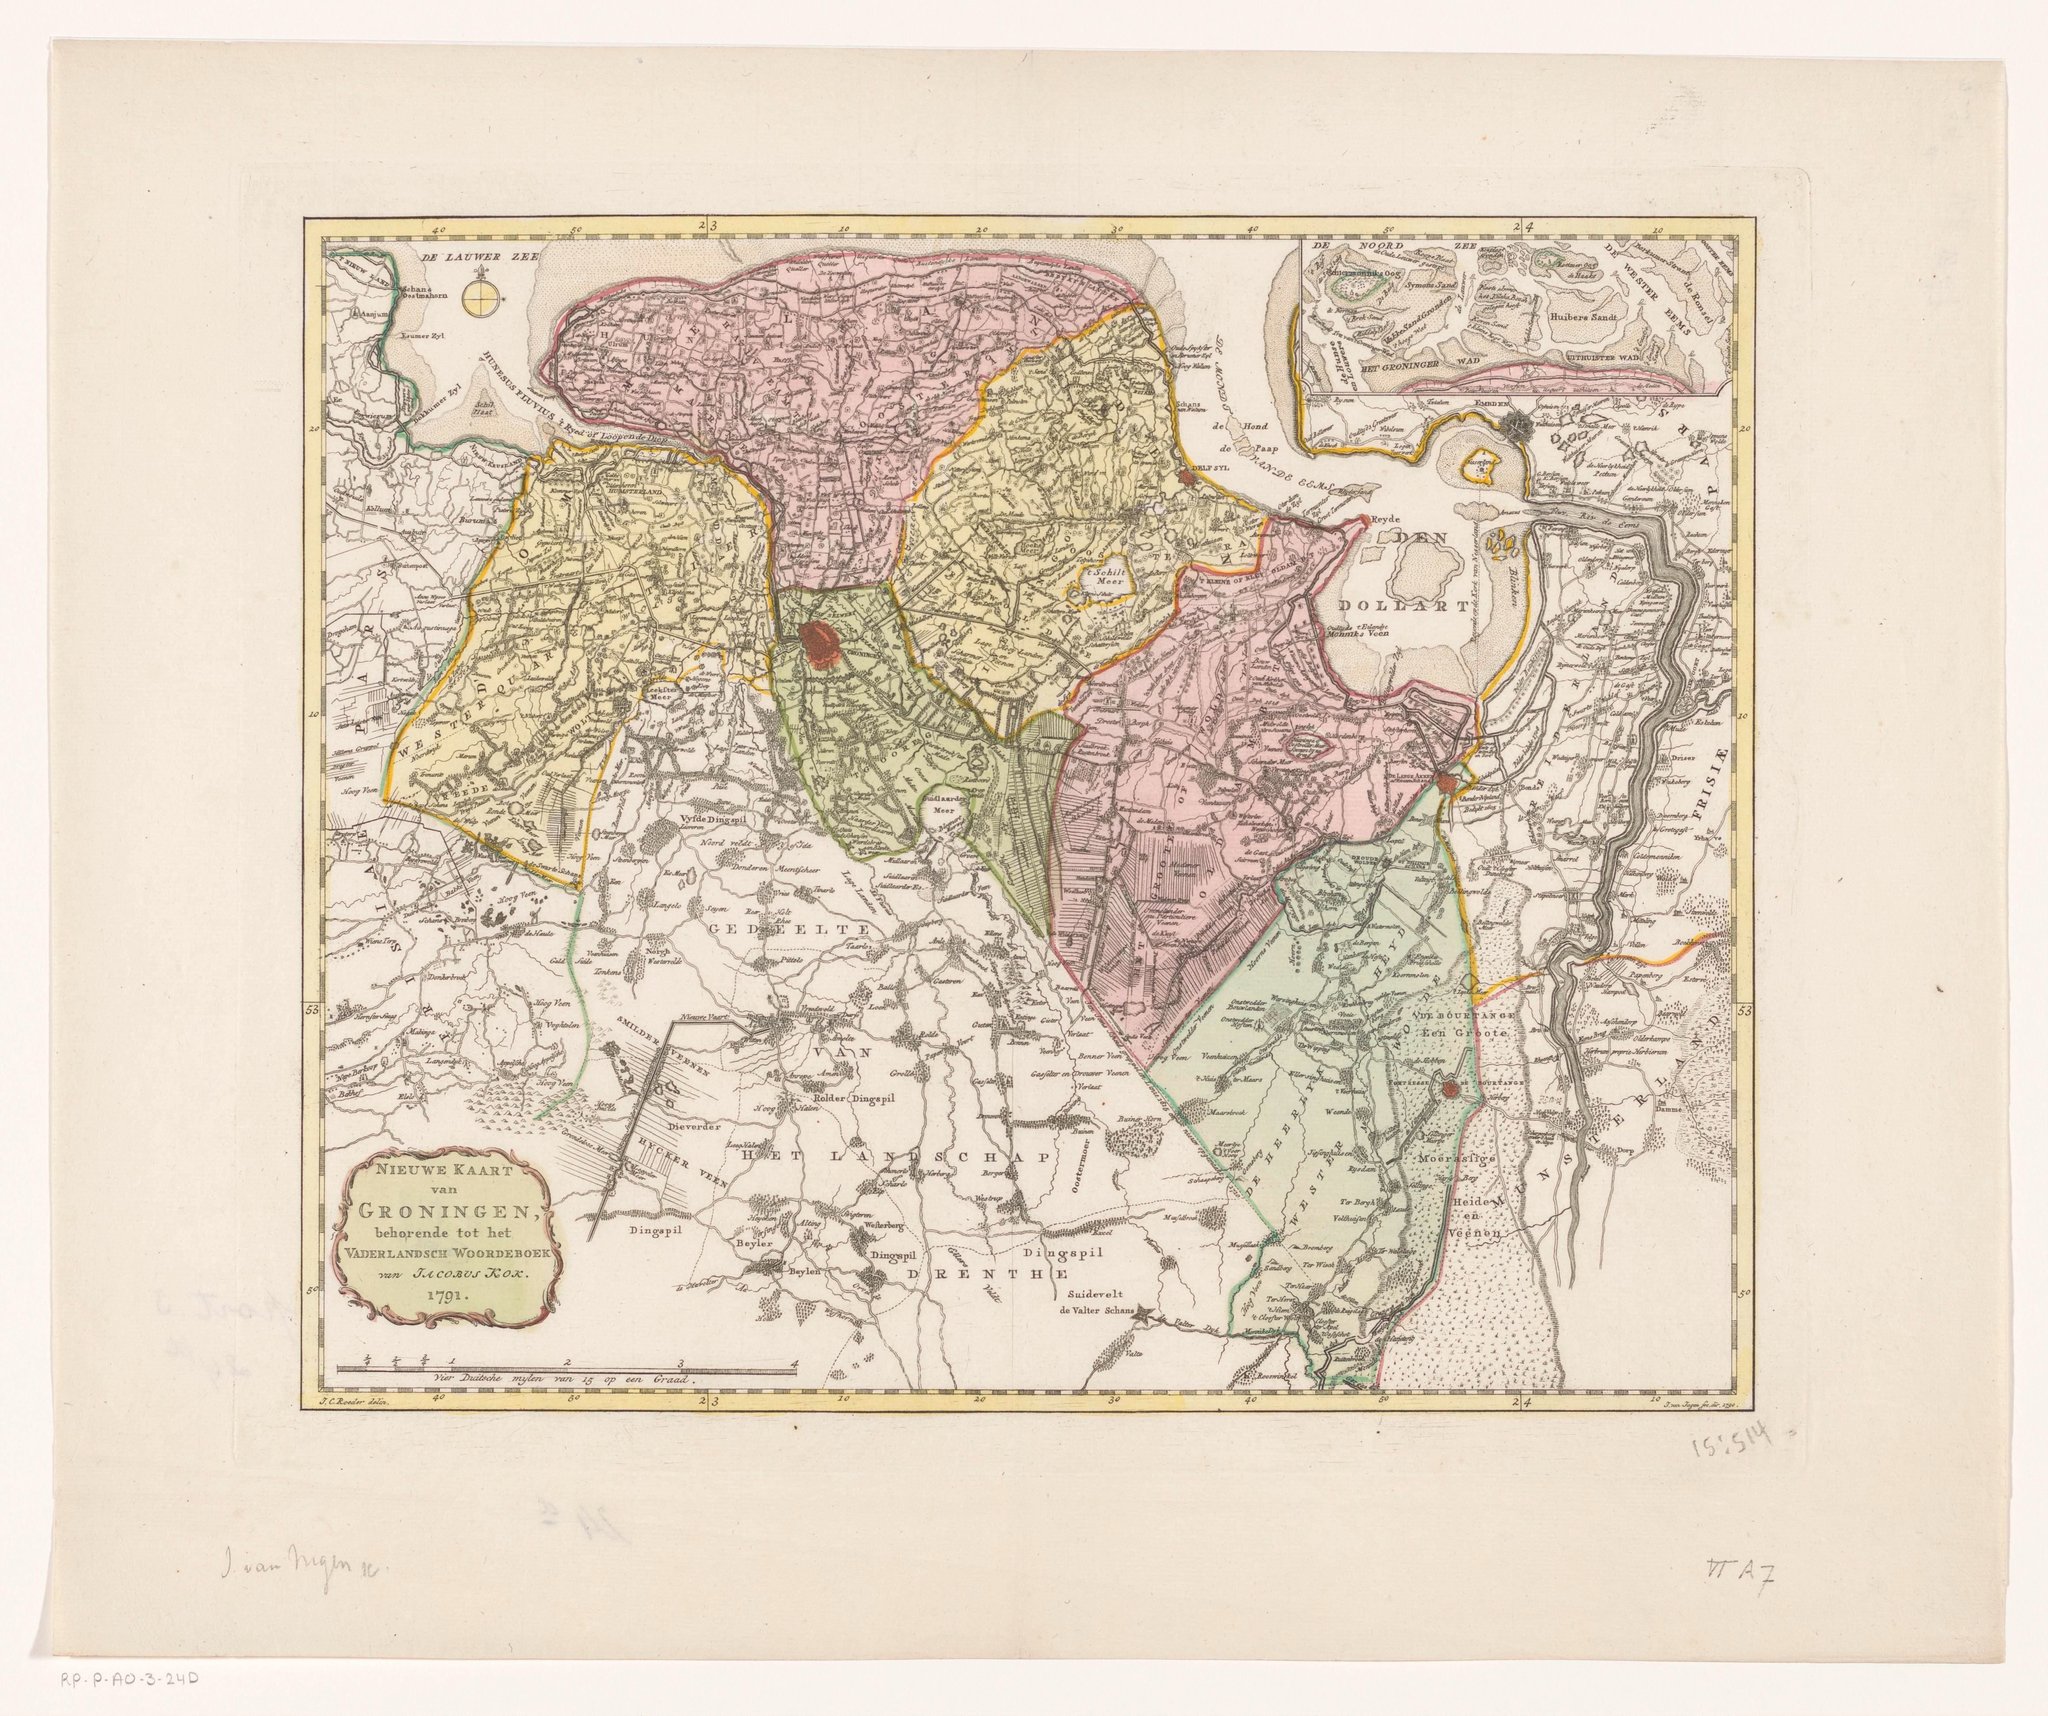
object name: print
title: Nieuwe kaart van Groningen, behorende tot het Vaderlandsch Woordenboek van Jacobus Kok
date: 1790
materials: paper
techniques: engraving, etching, hand coloring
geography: amsterdam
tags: maps of separate countries or regions, groningen (province)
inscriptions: collector's mark: Lugt 2228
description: Linksonder titelcartouche en een schaalstok: Vier Duitsche mylen van 15 op een graad. Rechtsboven een inzetkaart van het Waddengebied. Gradenverdeling langs de randen.